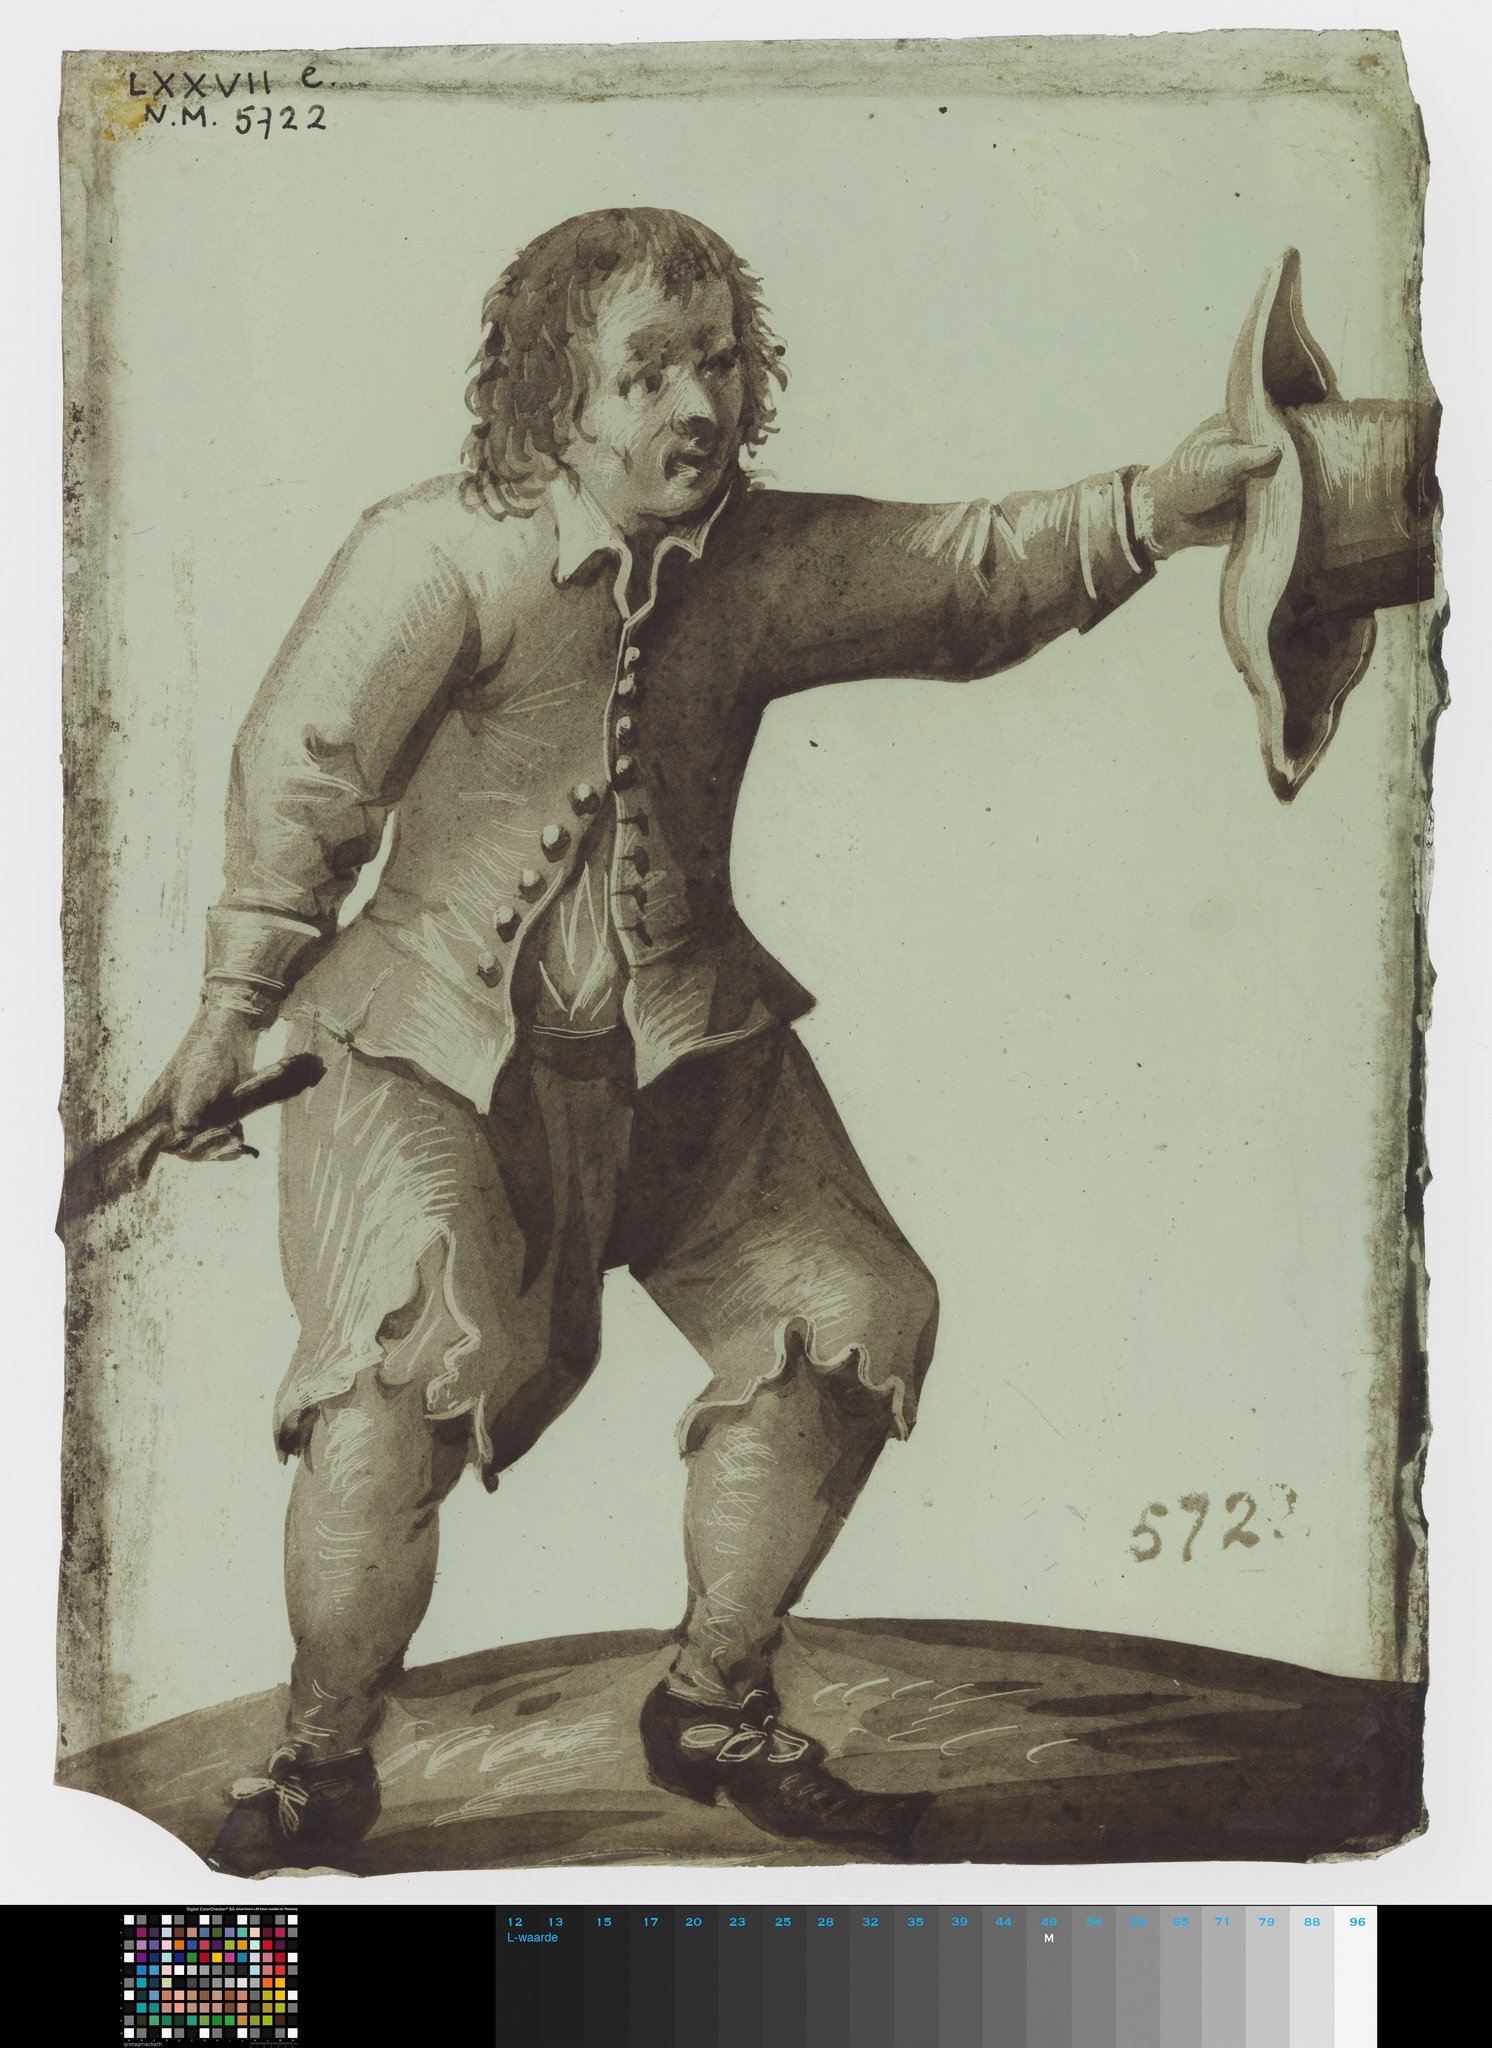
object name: light window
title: Ruit met een met het mes vechtende boer of burger die zijn hoed als schild voor zich houdt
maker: Anonymous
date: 1650-1700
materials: glass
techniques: enamel painting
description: Ruit van gebrandschilderd glas met een met het mes vechtende boer of burger die zijn hoed als schild voor zich houdt. Grauw. NM-5721/22 vormen één geheel. In tweeën gebroken.